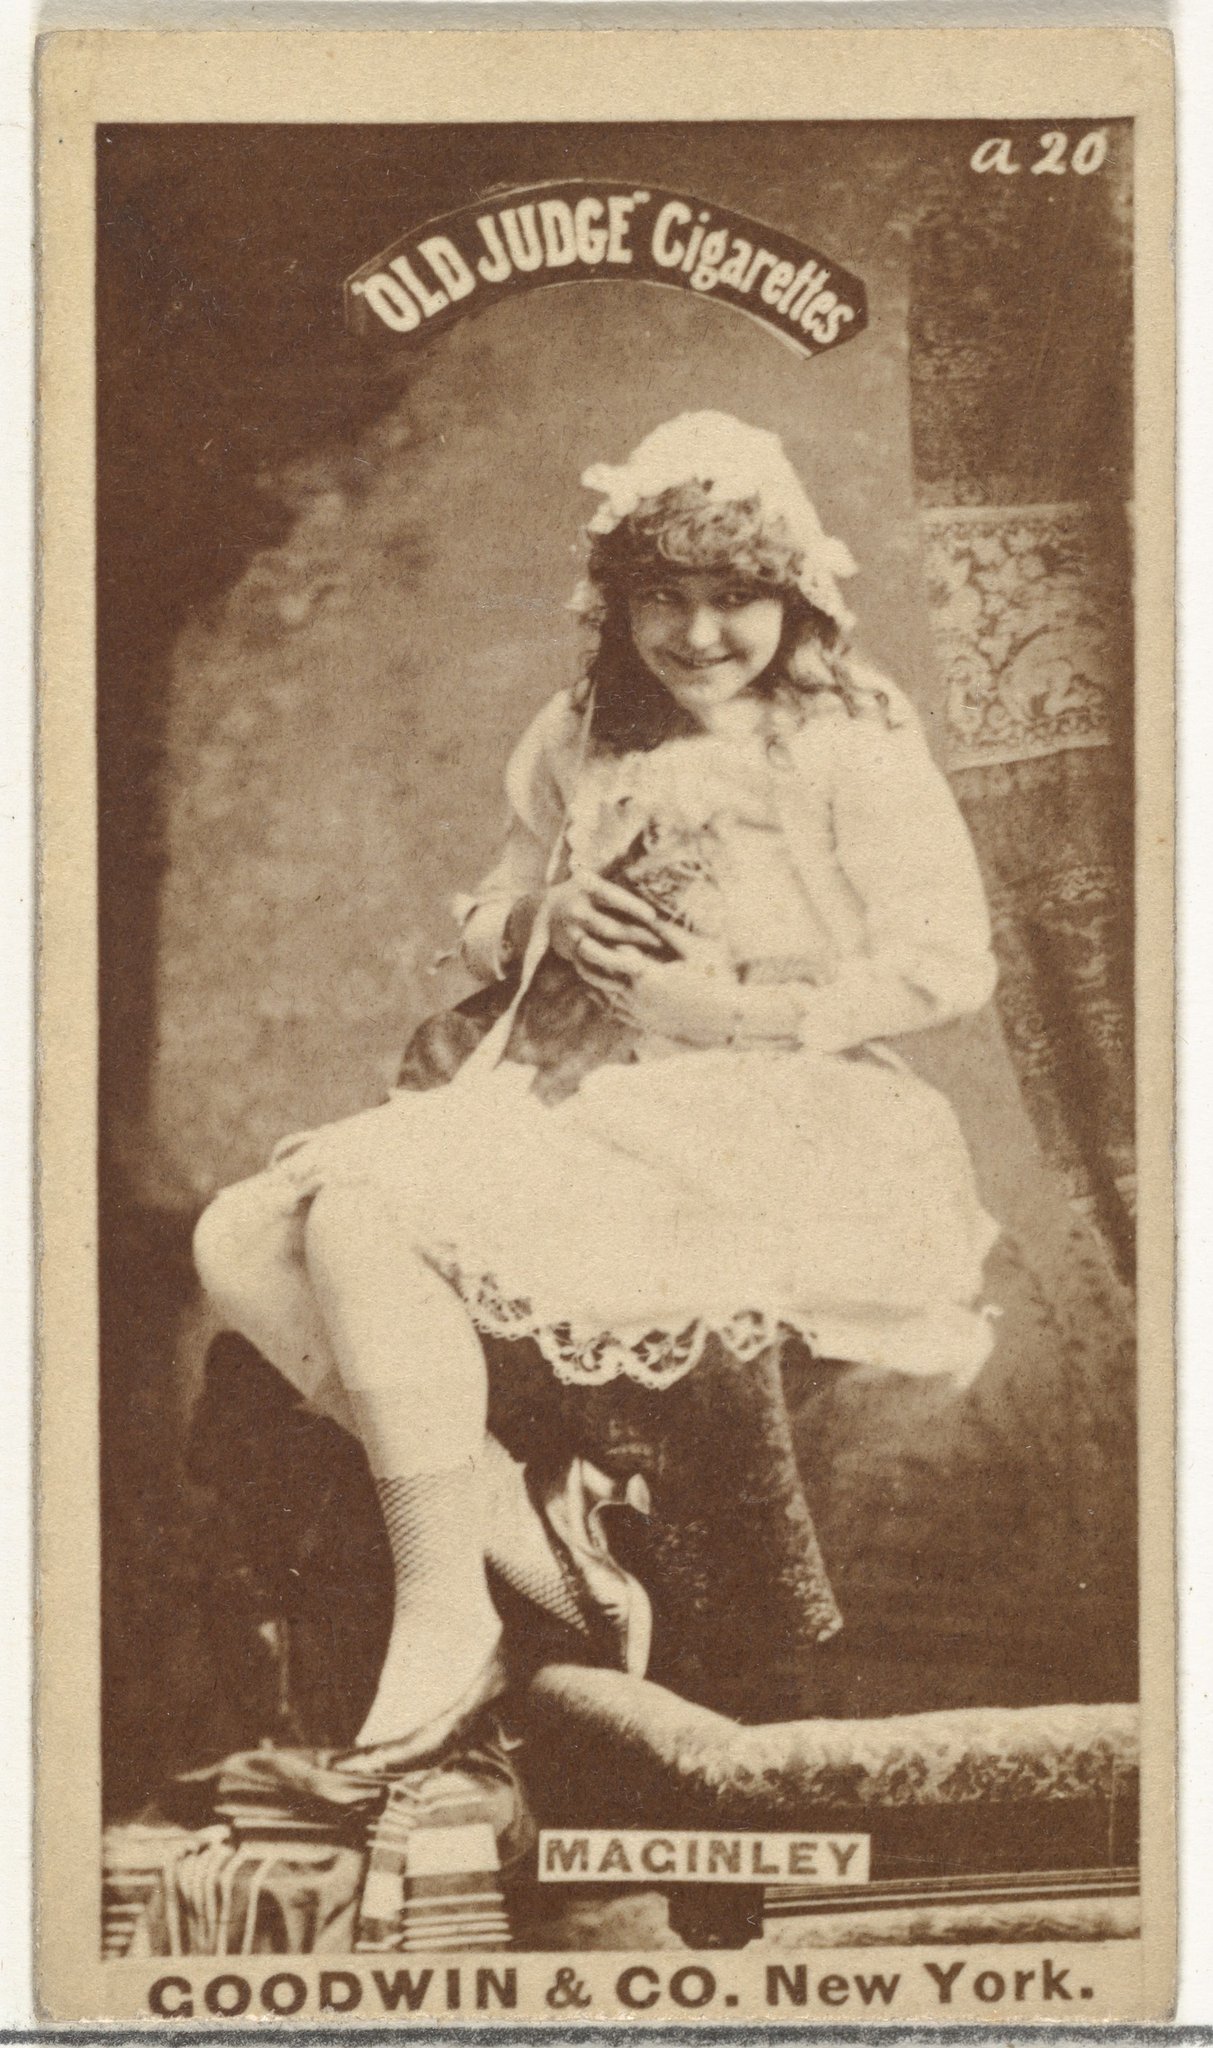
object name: photograph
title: Maginley, from the Actors and Actresses series (N171) for Old Judge Cigarettes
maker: goodwin & company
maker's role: publisher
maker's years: 1850-1950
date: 1886-1890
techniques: albumen silver print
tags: portraits,women,actresses